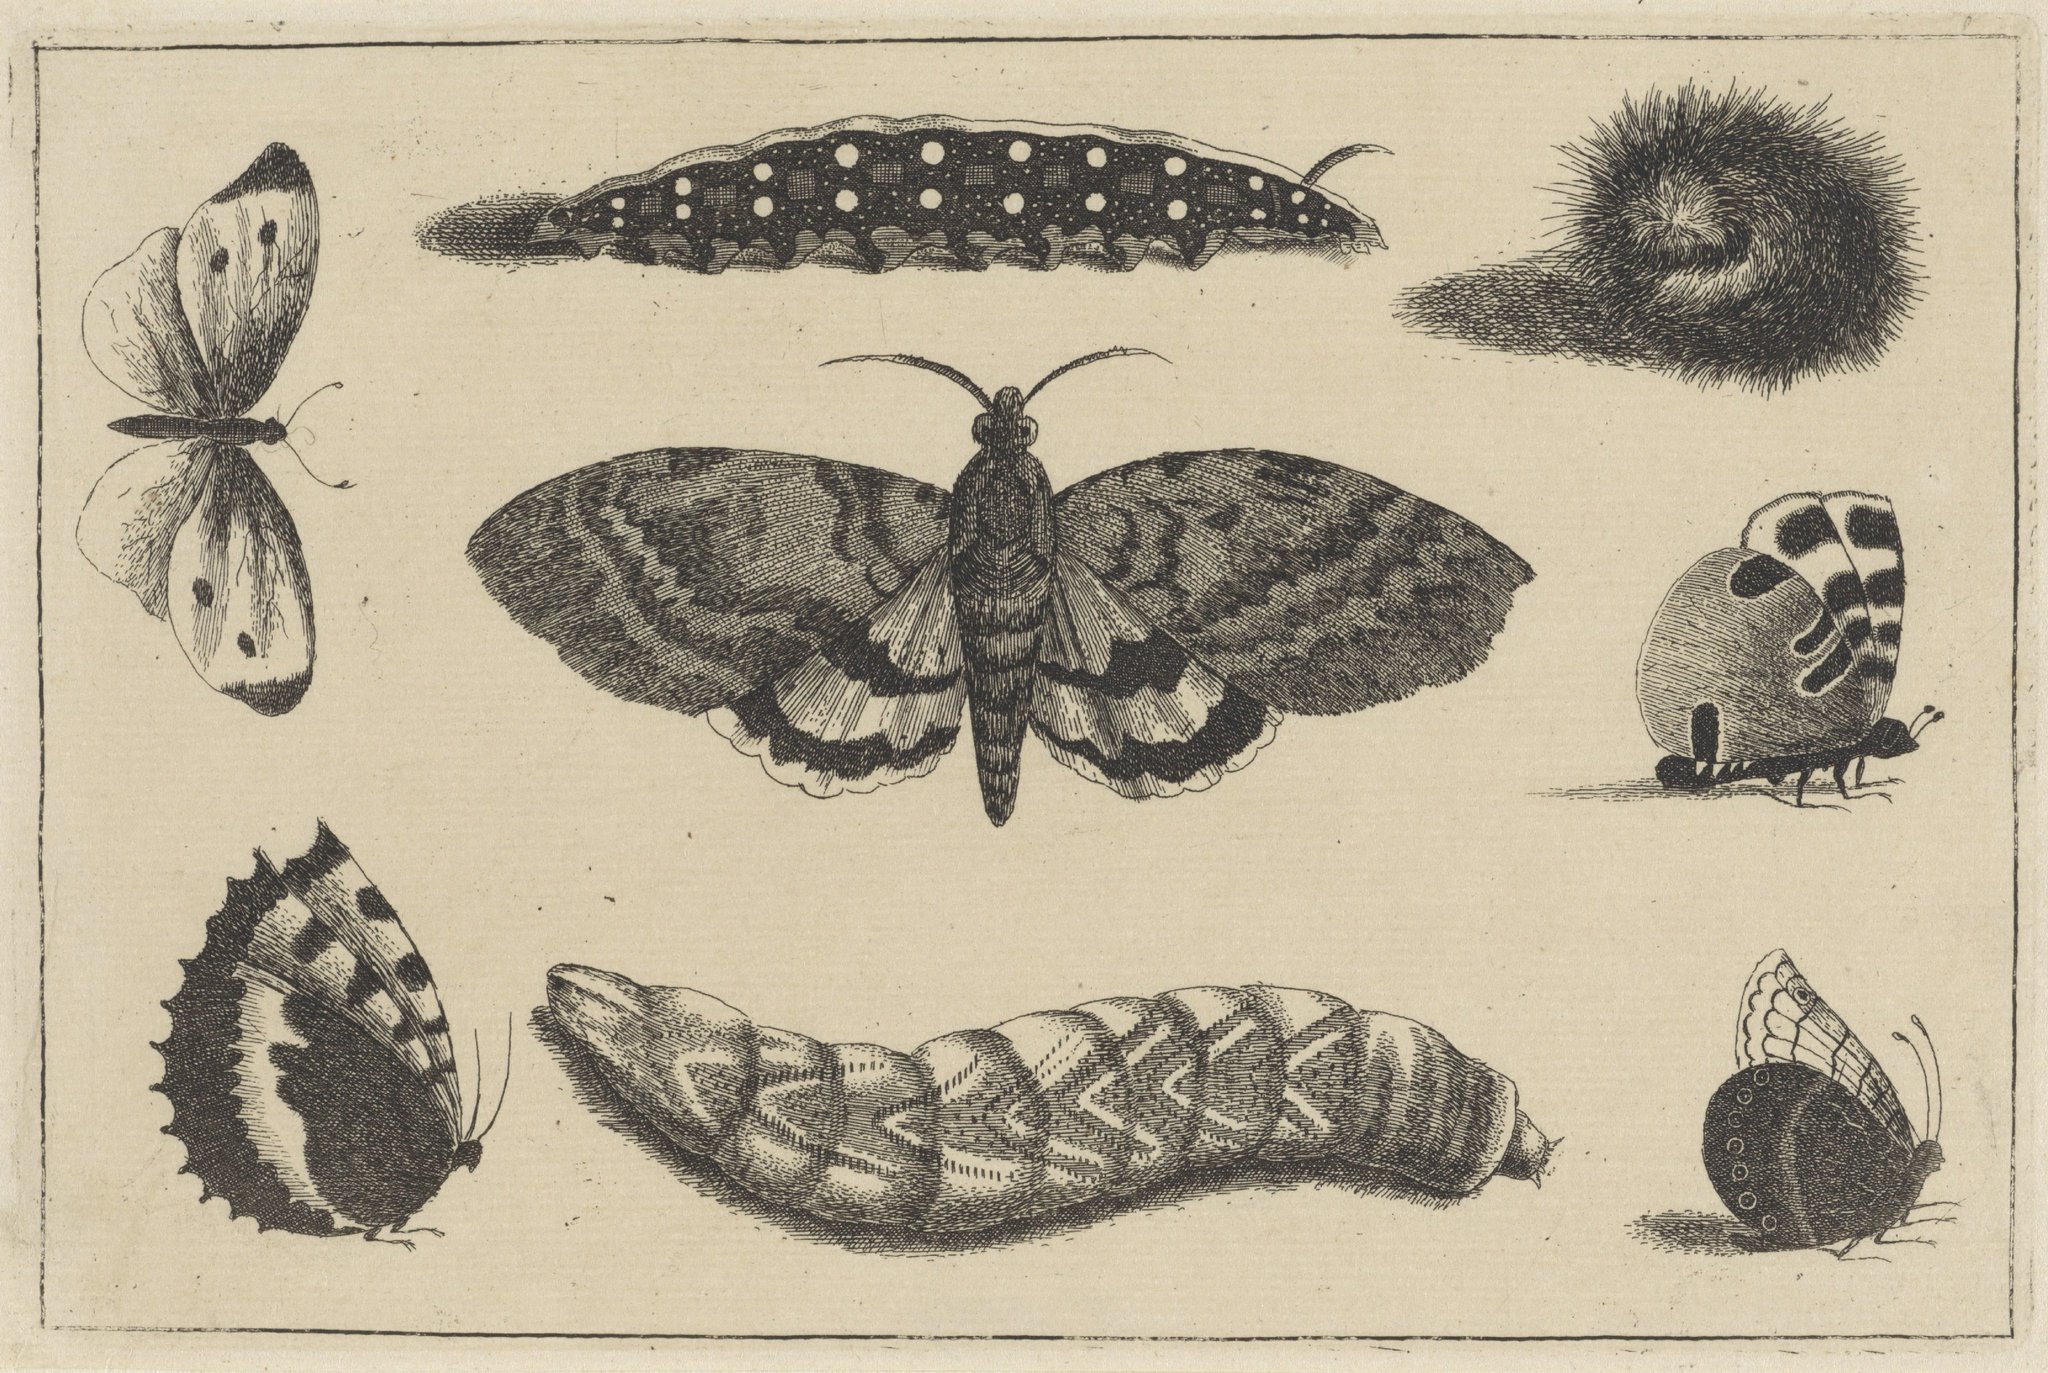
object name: print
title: Verschillende insecten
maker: wenceslaus hollar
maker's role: draughtsman, print maker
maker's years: 1607-1677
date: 1644-1652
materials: paper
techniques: etching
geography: antwerp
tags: insects: moth, insects: butterfly, insects: caterpillar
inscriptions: collector's mark: Lugt 2900, collector's mark: Lugt 2228, collector's mark: Lugt 975, collector's mark: Lugt 2773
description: Prent maakt deel uit van de achtdelige serie (incl. titelprent) met verschillende insecten: "Diversae Insectorum".